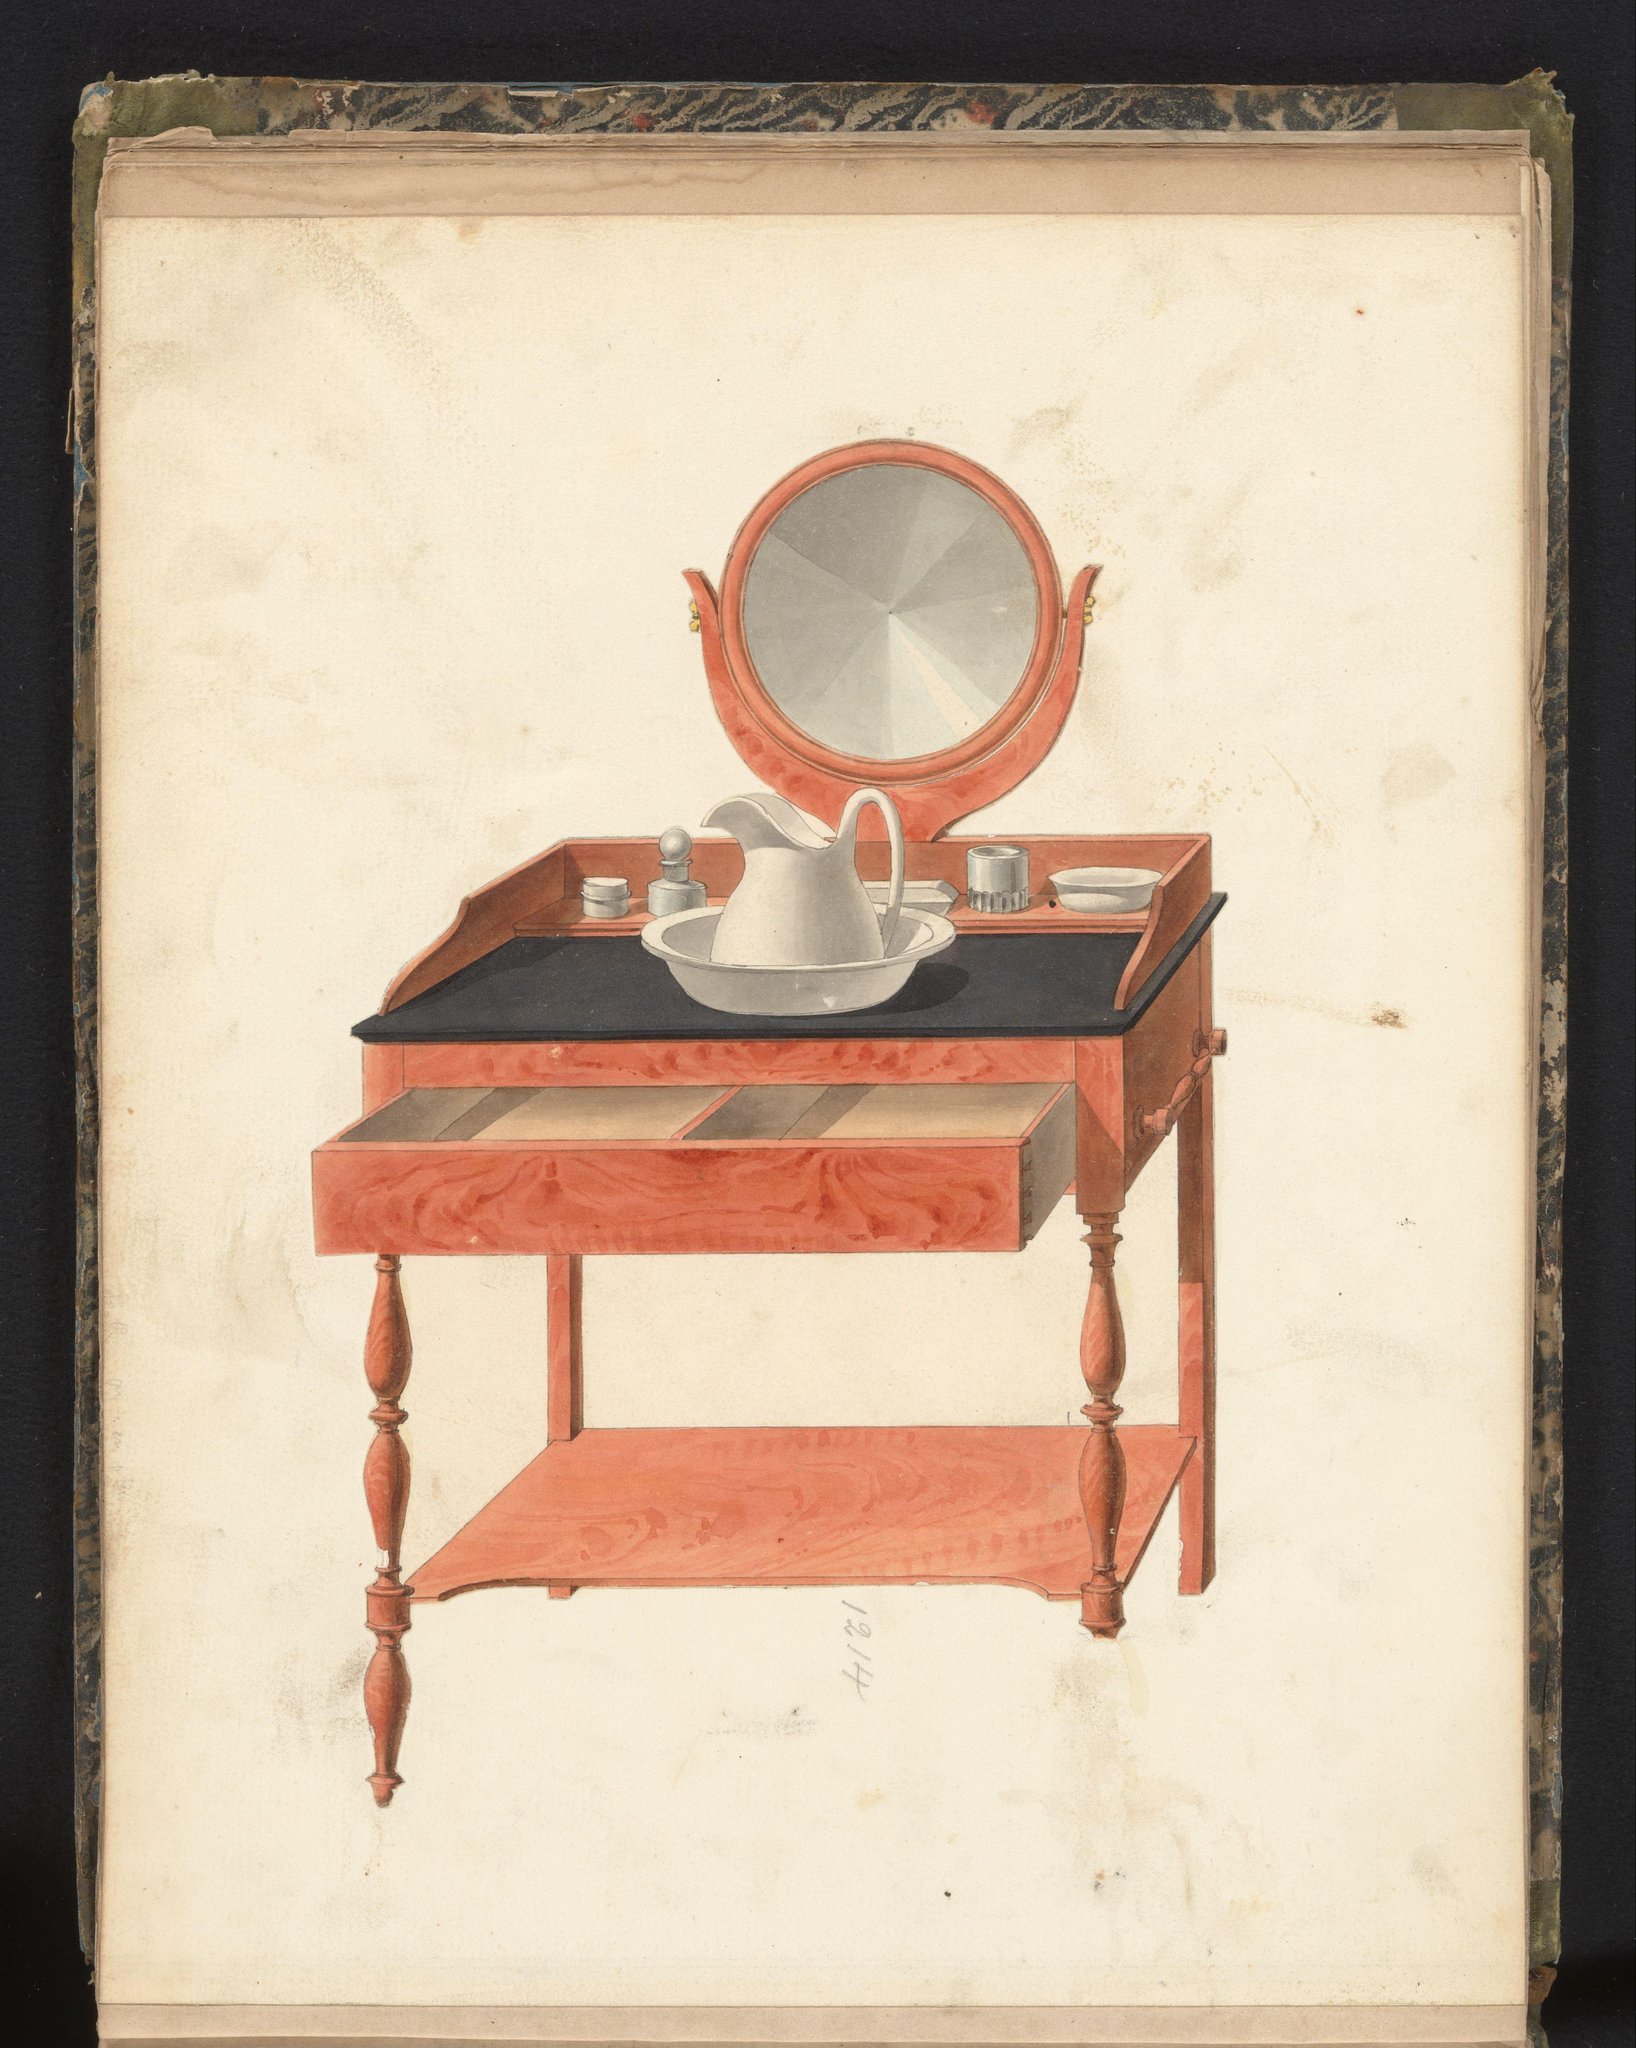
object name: album leaf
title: Ontwerp van een toilettafel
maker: Anonymous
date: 1825-1839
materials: ink, paper, pencil, watercolor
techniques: brush, pen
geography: paris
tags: mirror, jug and basin; wash-basin, furniture for special use (+ wood and other phytogenic material), table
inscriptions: inscription: ‘1214 Toilette Anglaise acajou 24 gre (gu) porcelaine & cristeaux ‘’…’’ 27 ‘’ ‘’…’’ 30 ‘’ Les même en noyer en moins’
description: Ontwerp van een toilettafel met spiegel, vervaardigd in mahoniehout. Het blad op de achterzijde genummerd: 7, het tegenoverliggende blad met informatie over de afgebeelde meubelen genummerd: 7 bis. Onderdeel van een album met 80 bladen met tekeningen en een prent van gefineerde en gelakte meubelen, alsmede zitmeubelen.